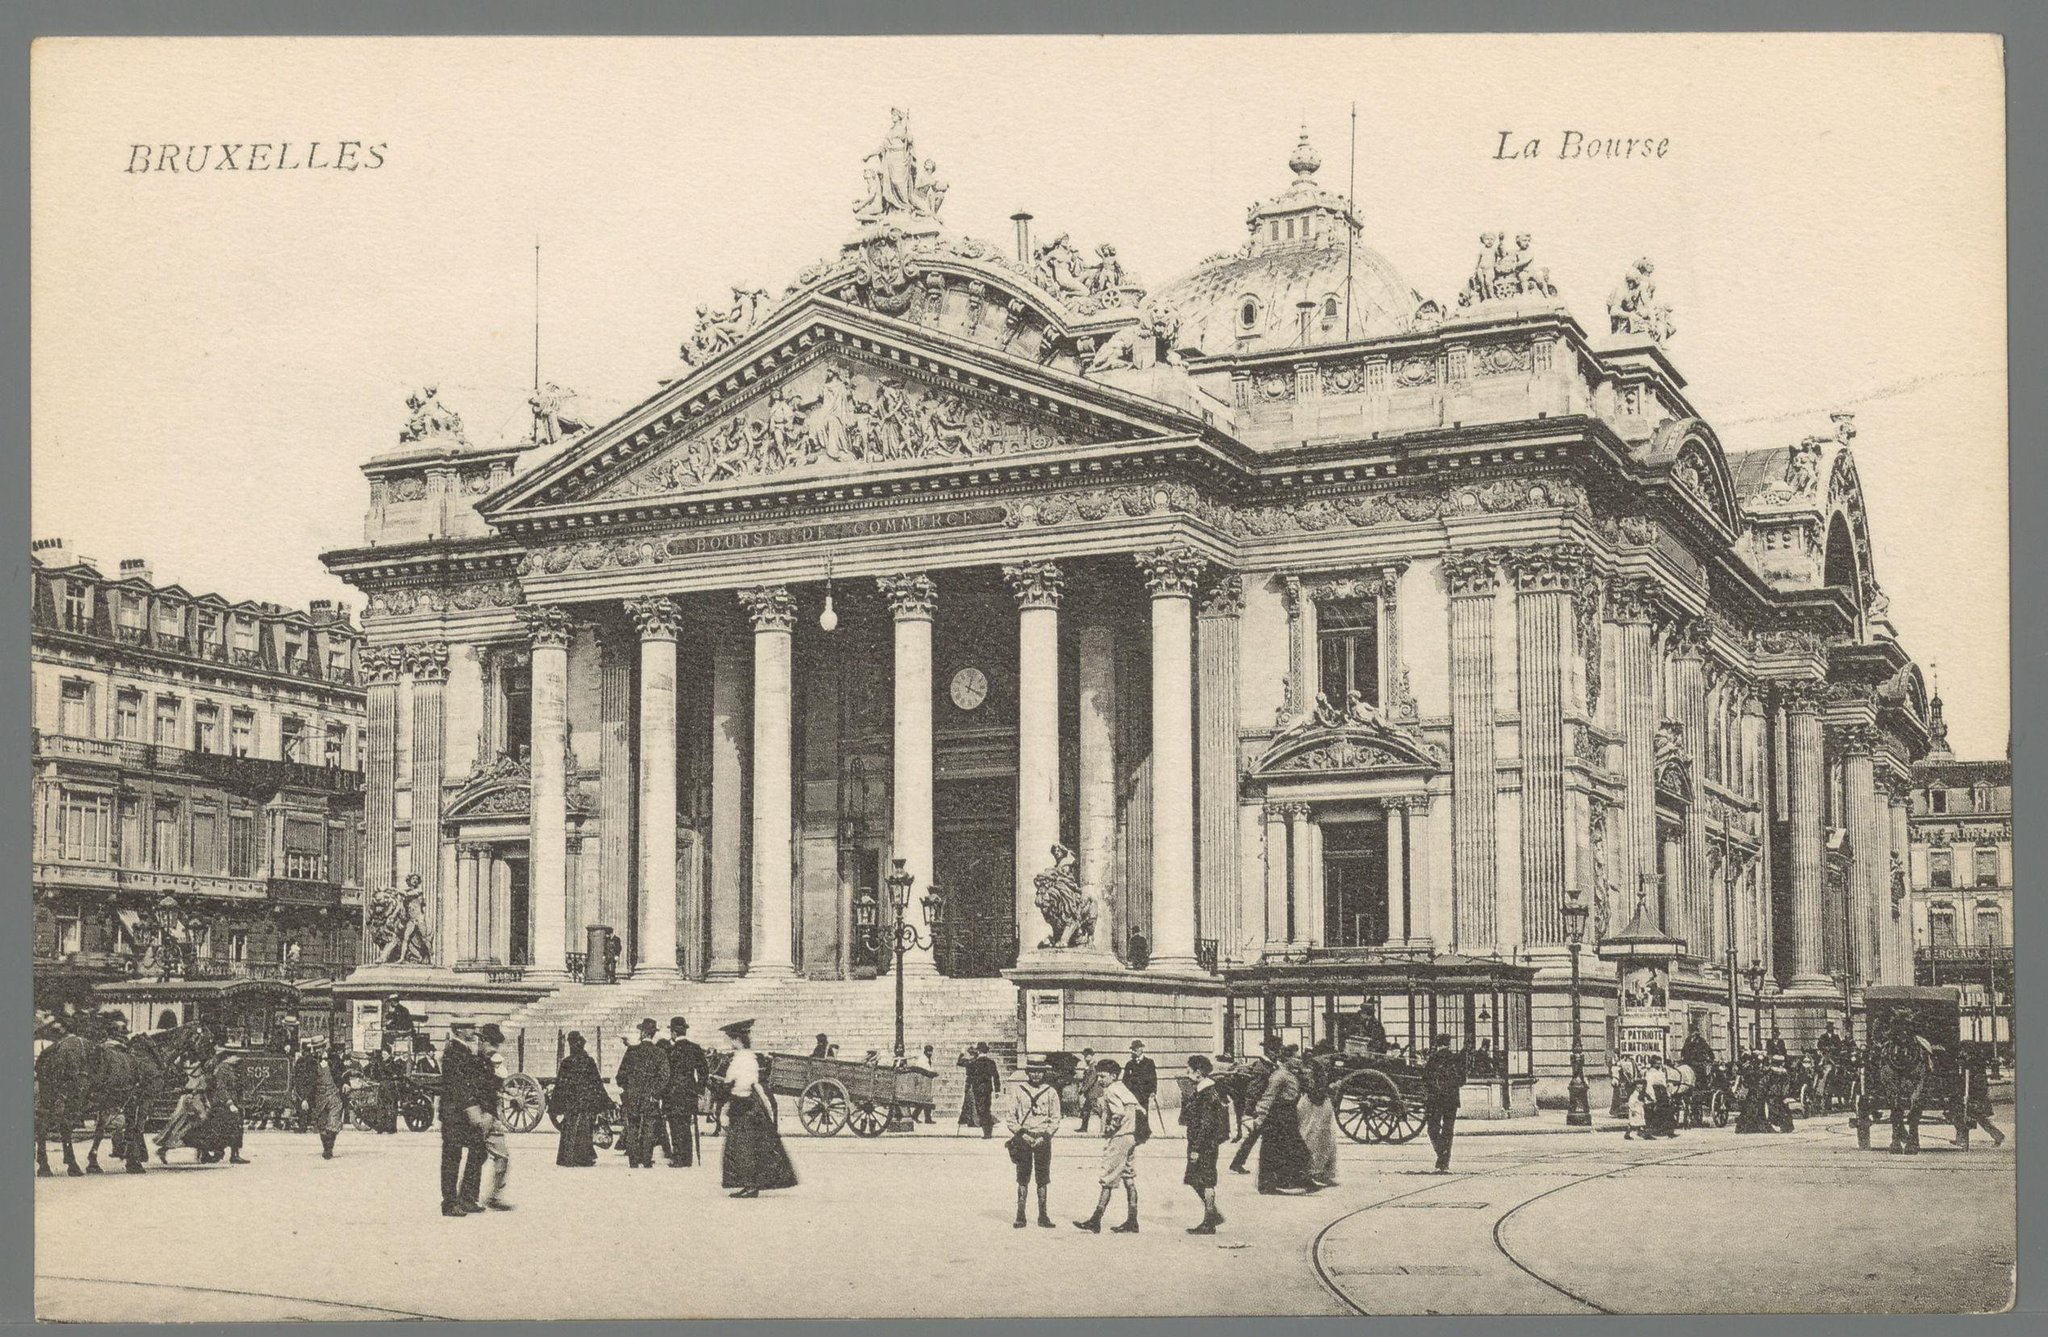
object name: photomechanical print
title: Bruxelles. La Bourse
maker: Anonymous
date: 1906-1930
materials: cardboard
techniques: photograph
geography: brussels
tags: exchange, bourse, square, place, circus, etc. (+ city(-scape) with figures, staffage)